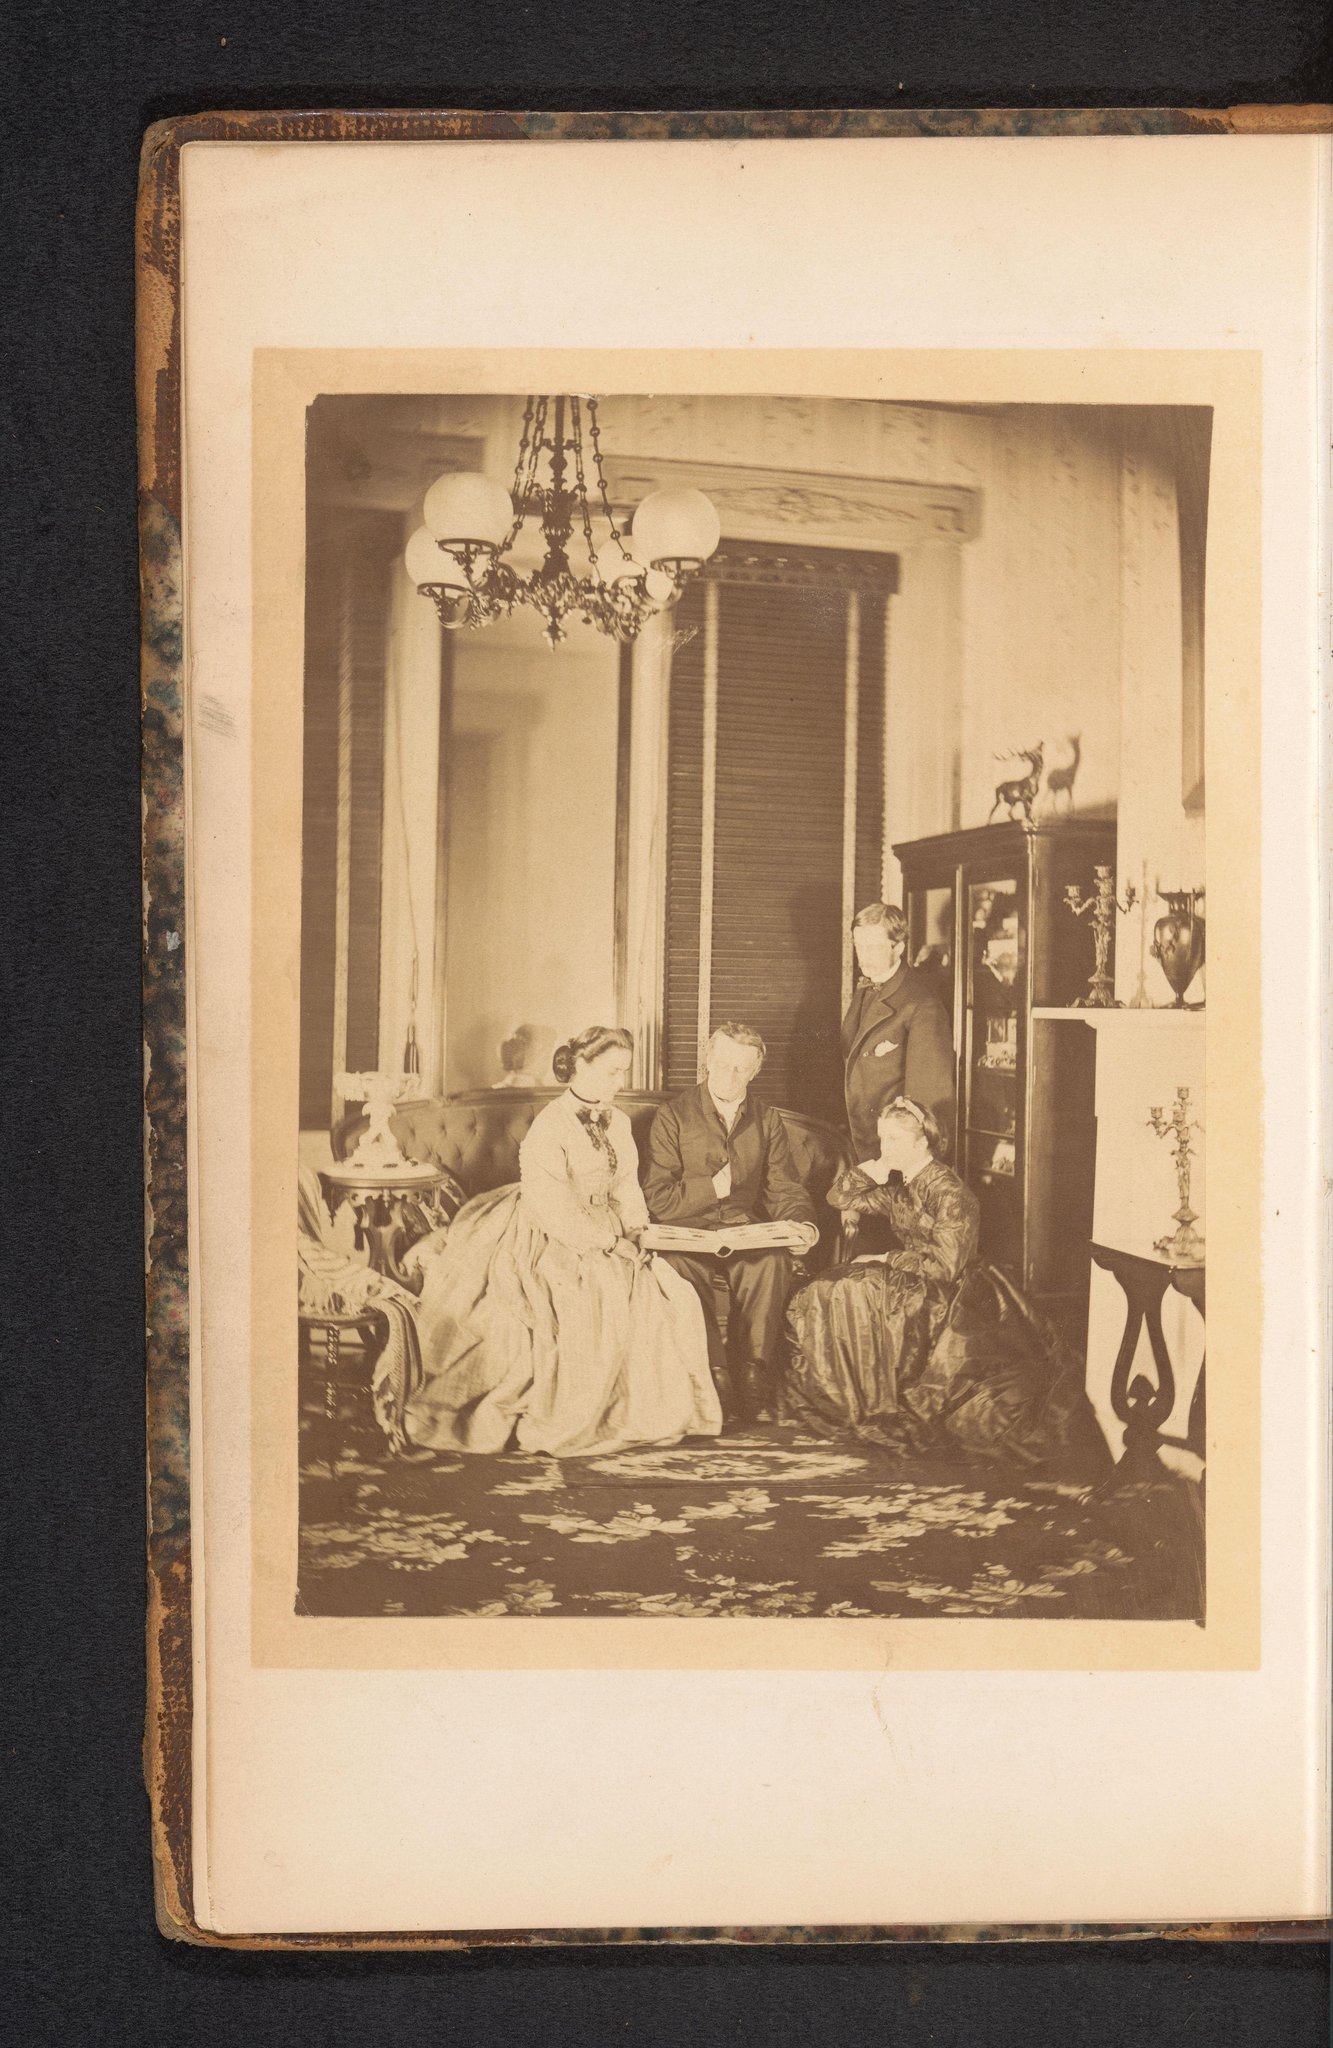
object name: page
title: Twee mannen en twee vrouwen bekijken een fotoalbum in een woonkamer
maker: j.c. browne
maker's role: fotograaf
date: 1861-1866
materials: photographic support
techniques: albumen print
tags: adult woman, adult man, living-room, parlour, sitting-room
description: Foto tegenover pagina 1, achter semi-transparante omslag.